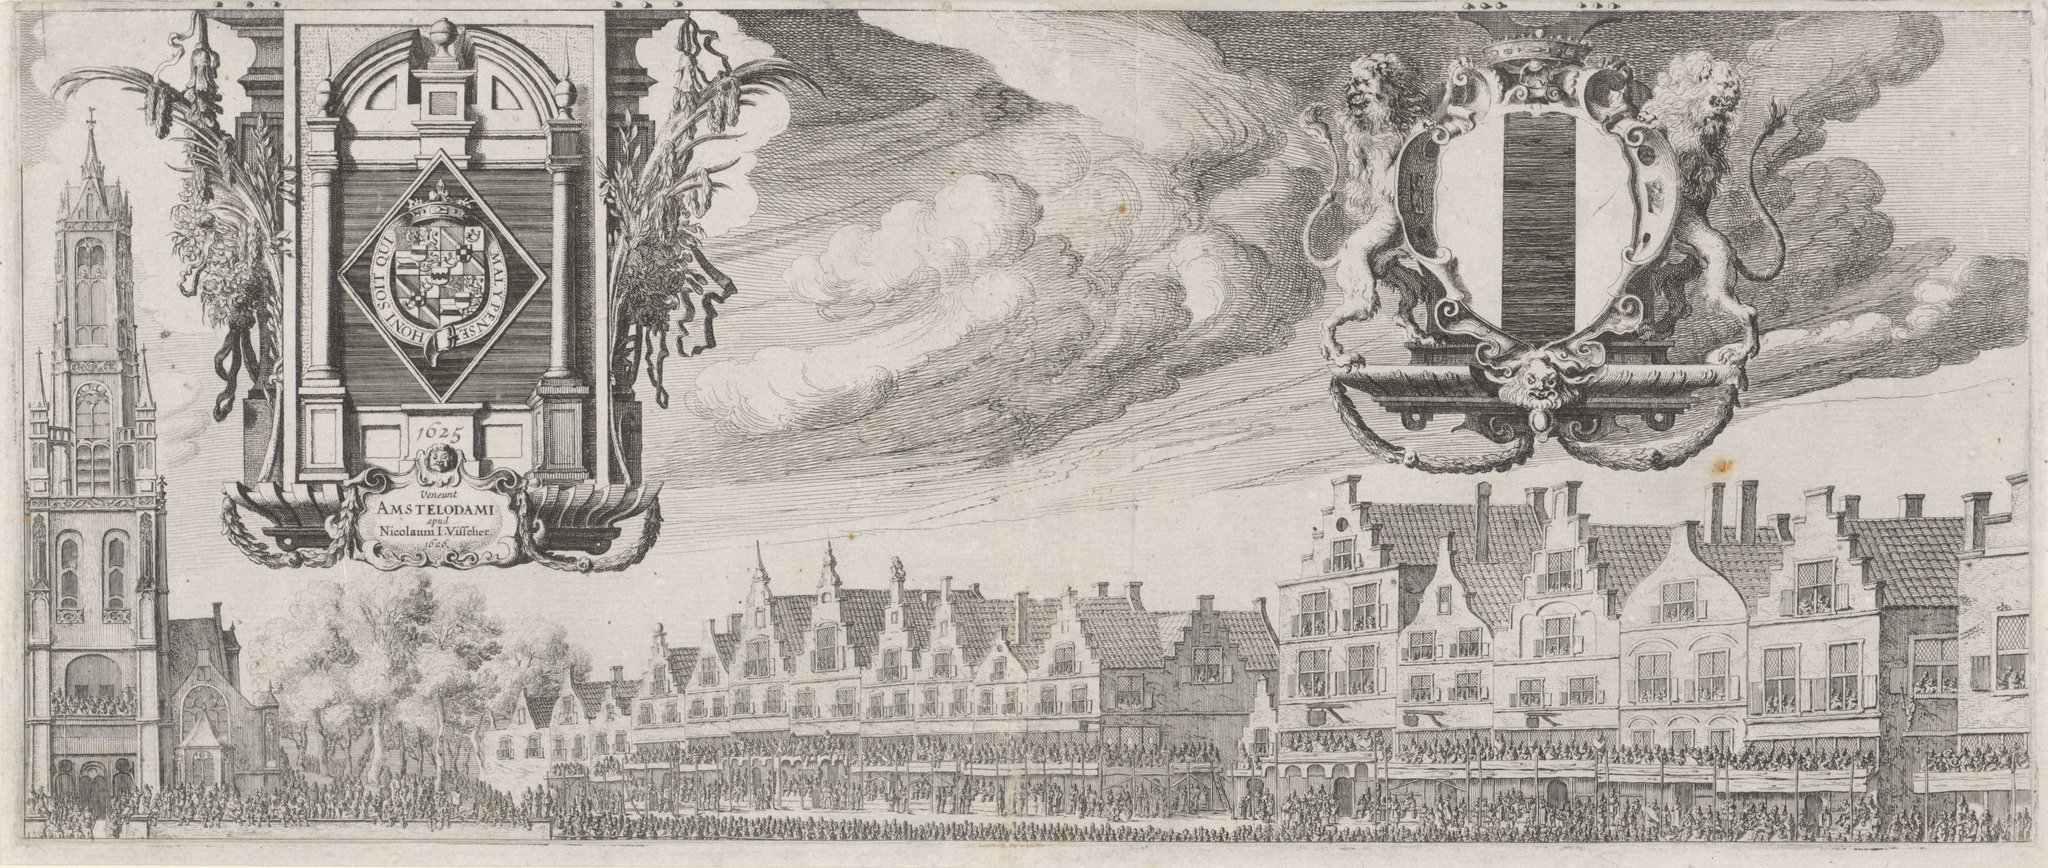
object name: print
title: Lijkstatie van prins Maurits in 1625, deel rechtsboven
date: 1625-1626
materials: paper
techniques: etching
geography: amsterdam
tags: the hague, maurice (prince of orange), cortege, funeral procession, historical events and situations, delft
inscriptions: collector's mark: Lugt 963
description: De begrafenisstoet van prins Maurits te Delft op 16 september 1625. Grote voorstelling van de ceremonie, bestaande uit 4 te monteren bladen, een titel en bijbehorende tekstblaadjes (genummerd 1-12). Dit is het blad rechtsboven, met de Nieuwe Kerk en andere gebouwen aan de Grote Markt te Delft, in de lucht het wapen van Maurits in een architecturale omlijsting en het stadswapen van Delft.